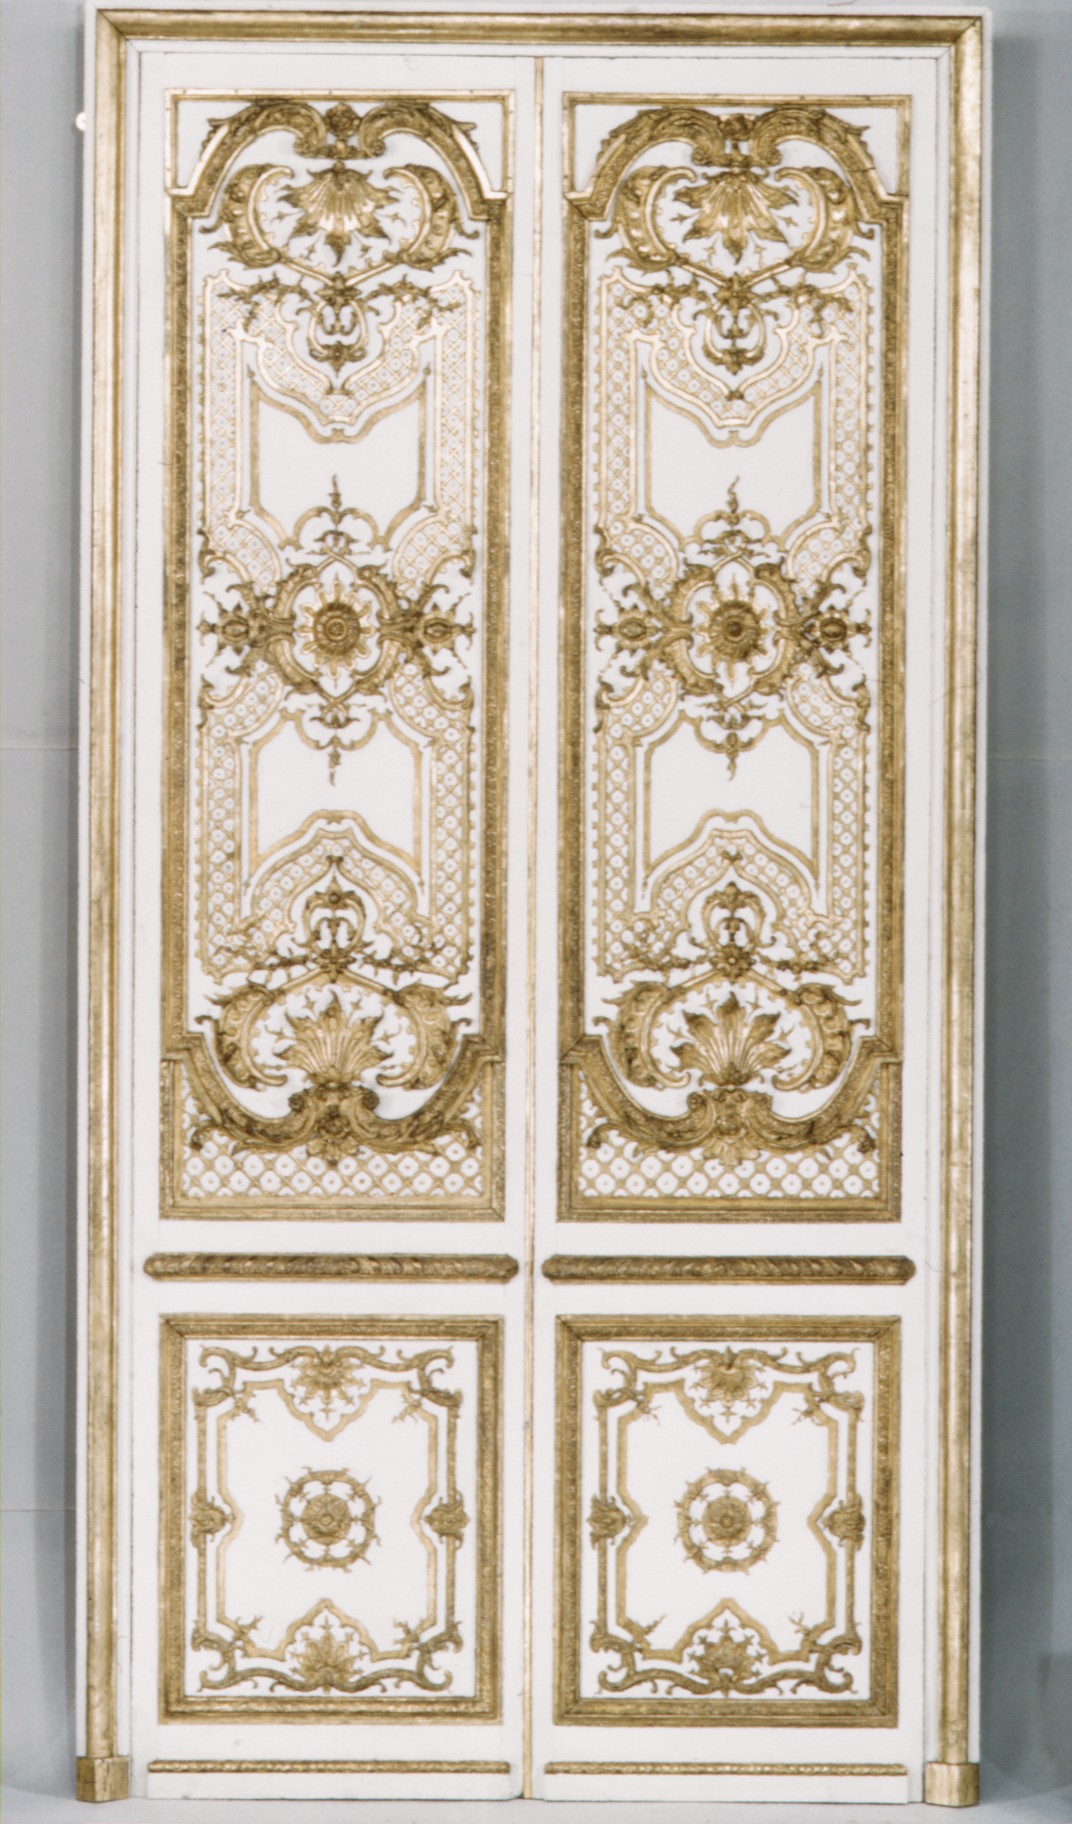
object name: double door, panel, pilaster, door frame molding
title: Double door: four panels, two pilasters, three gilt moldings for the door frame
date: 1715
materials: wood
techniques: carving, gilding, painting